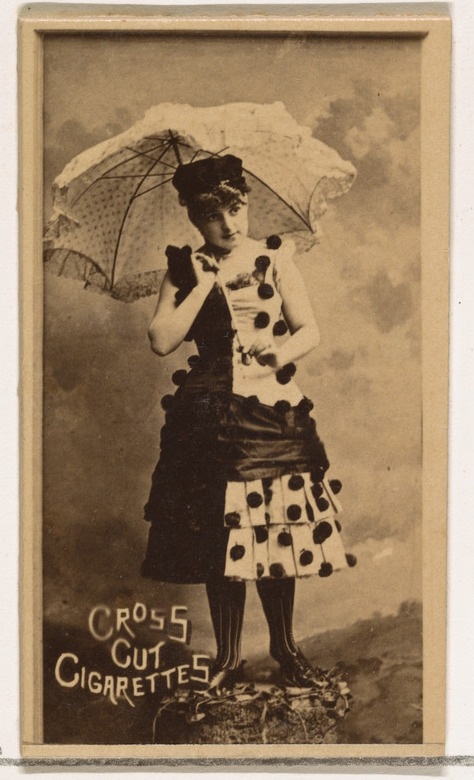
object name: print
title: Actress holding parasol, from the Actors and Actresses series (N145-1) issued by Duke Sons & Co. to promote Cross Cut Cigarettes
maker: w. duke, sons & co.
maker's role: publisher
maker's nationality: american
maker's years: 1870-1920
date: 1880-1889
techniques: albumen silver print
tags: portraits,women,actresses,parasols